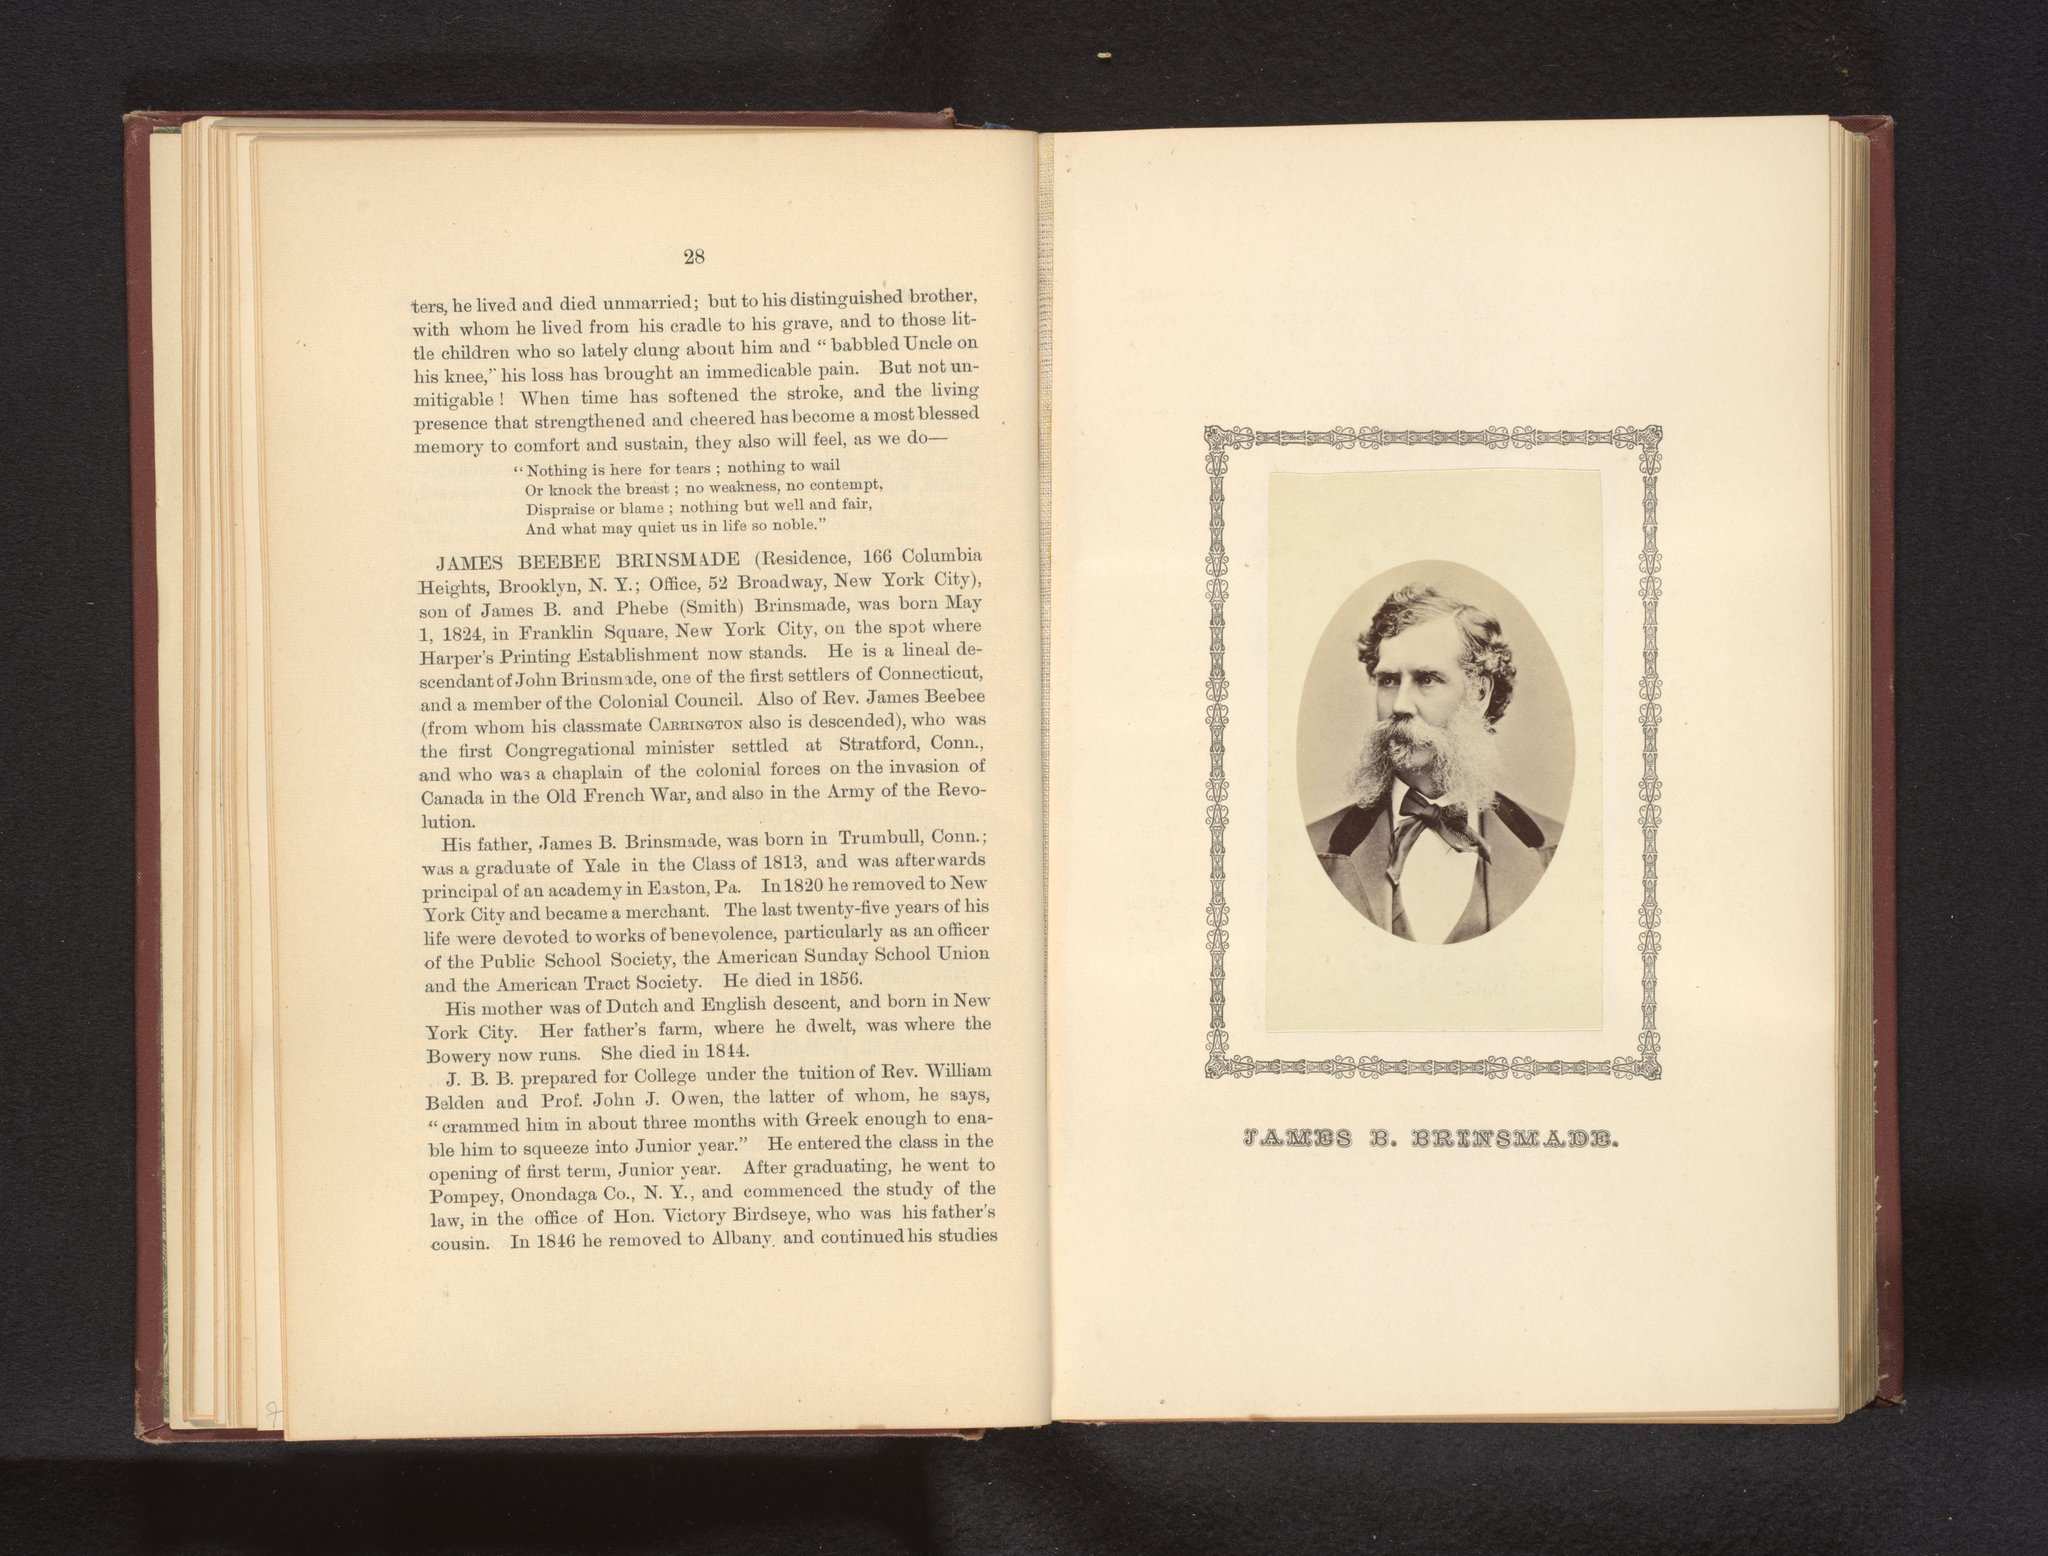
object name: photograph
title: James B. Brinsmade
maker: Anonymous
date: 1876-1881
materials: photographic support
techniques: albumen print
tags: adult man